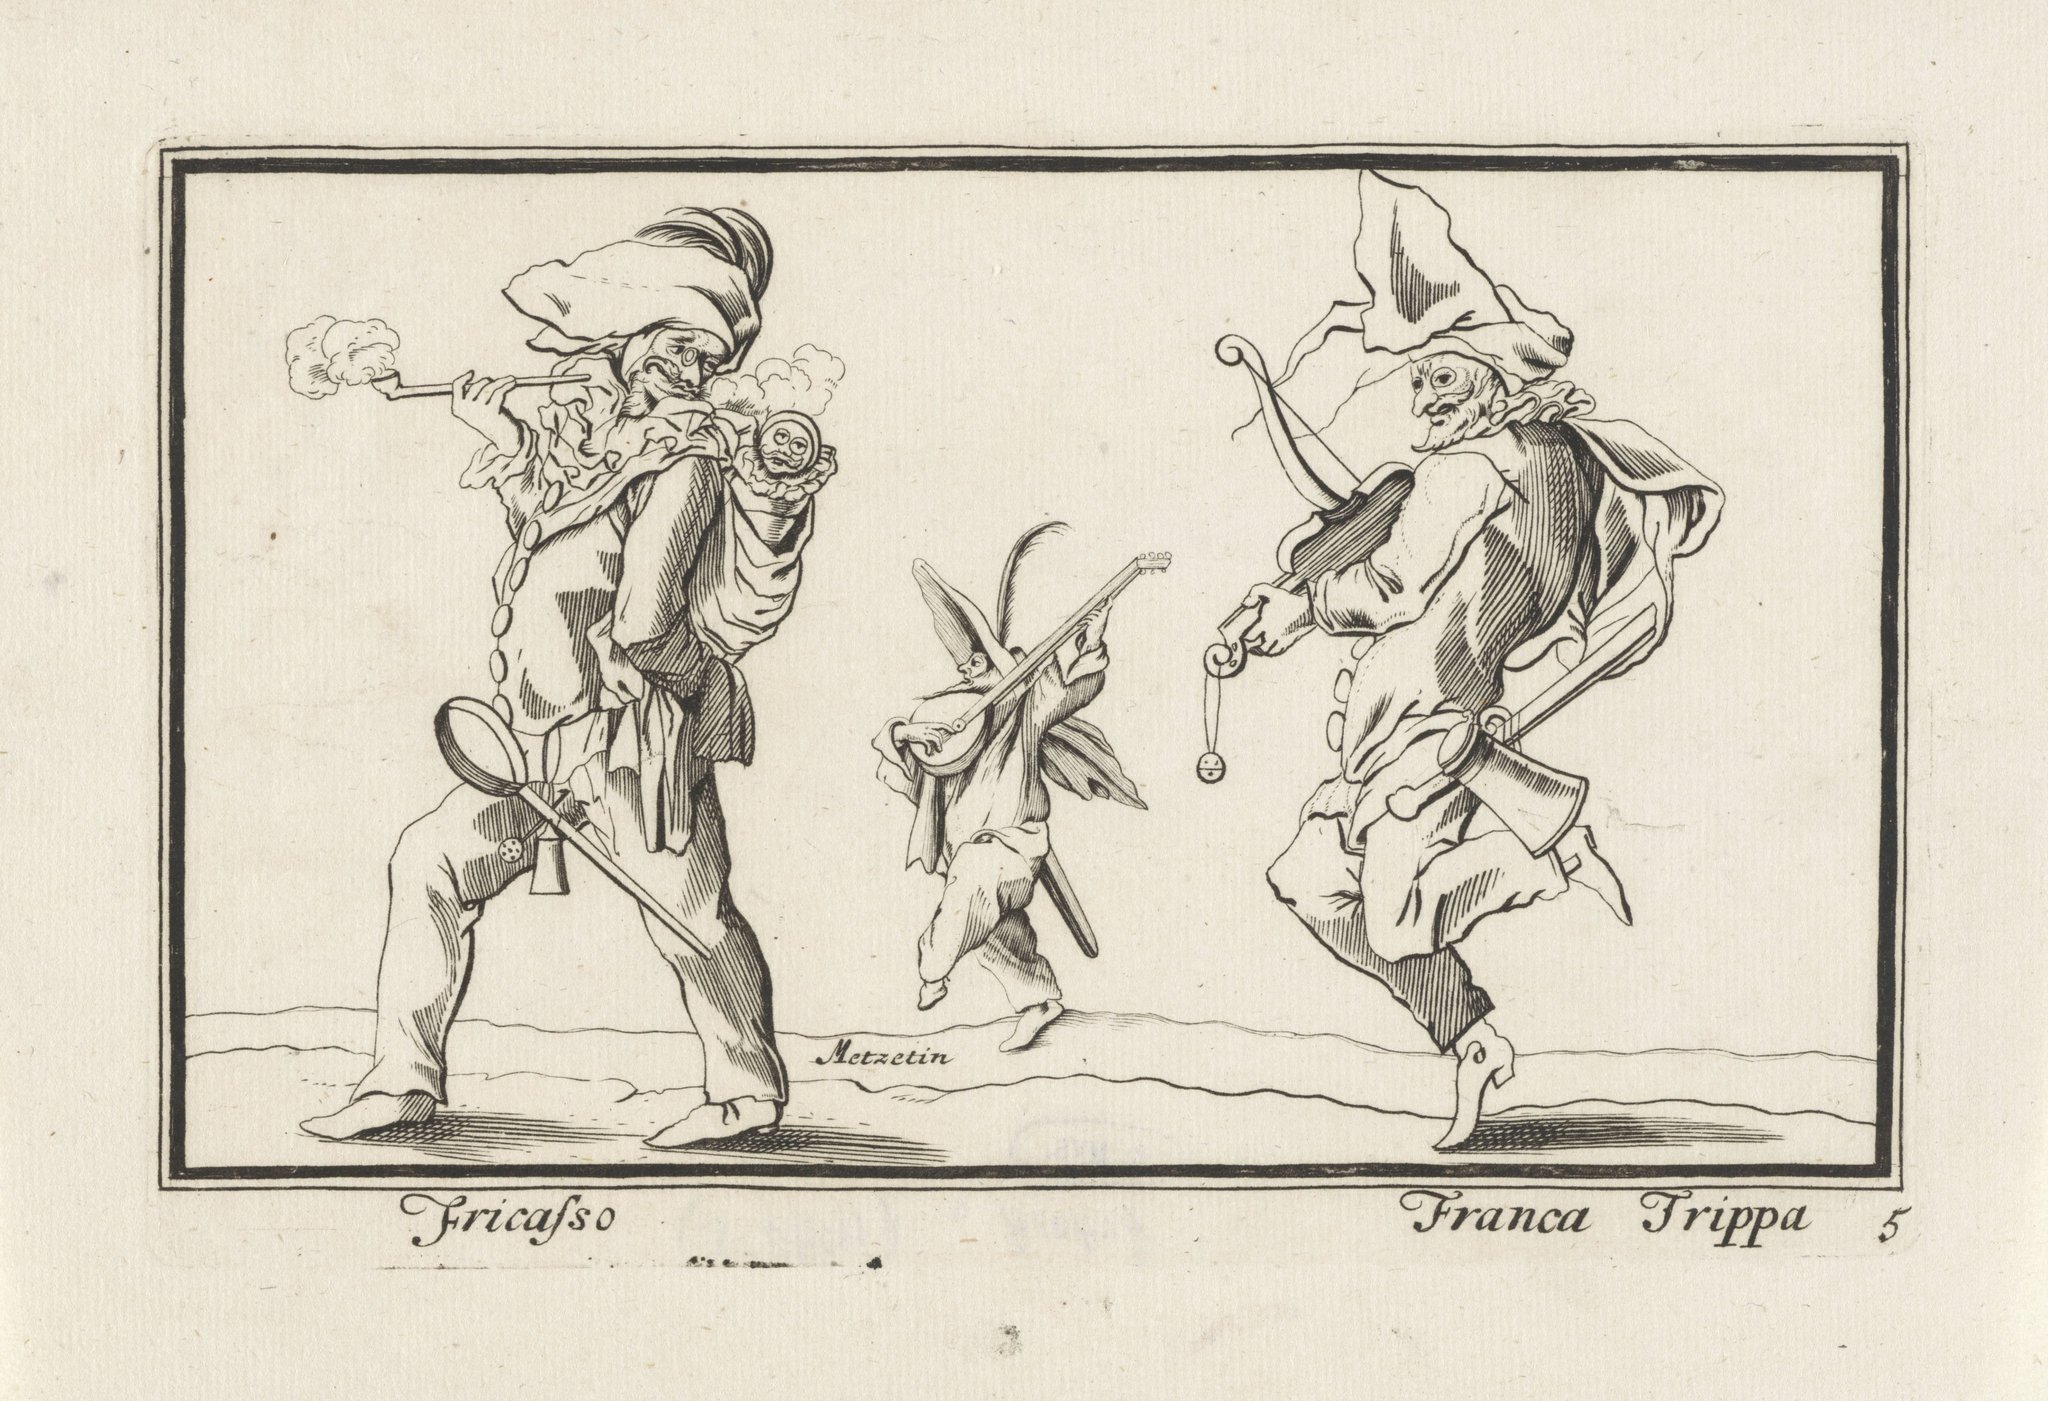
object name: print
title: Personages uit de commedia dell'arte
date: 1668-1707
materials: paper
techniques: etching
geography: northern netherlands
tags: types in 'commedia dell'arte'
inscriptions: collector's mark: Lugt 2228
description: Drie personages uit de commedia dell'arte. Links Fricasso met een pijp en een kleine oude man als een zuigeling op zijn rug gebonden. In het midden Mezzetino met een luit. Rechts Franca Trippa die een viool bespeelt.